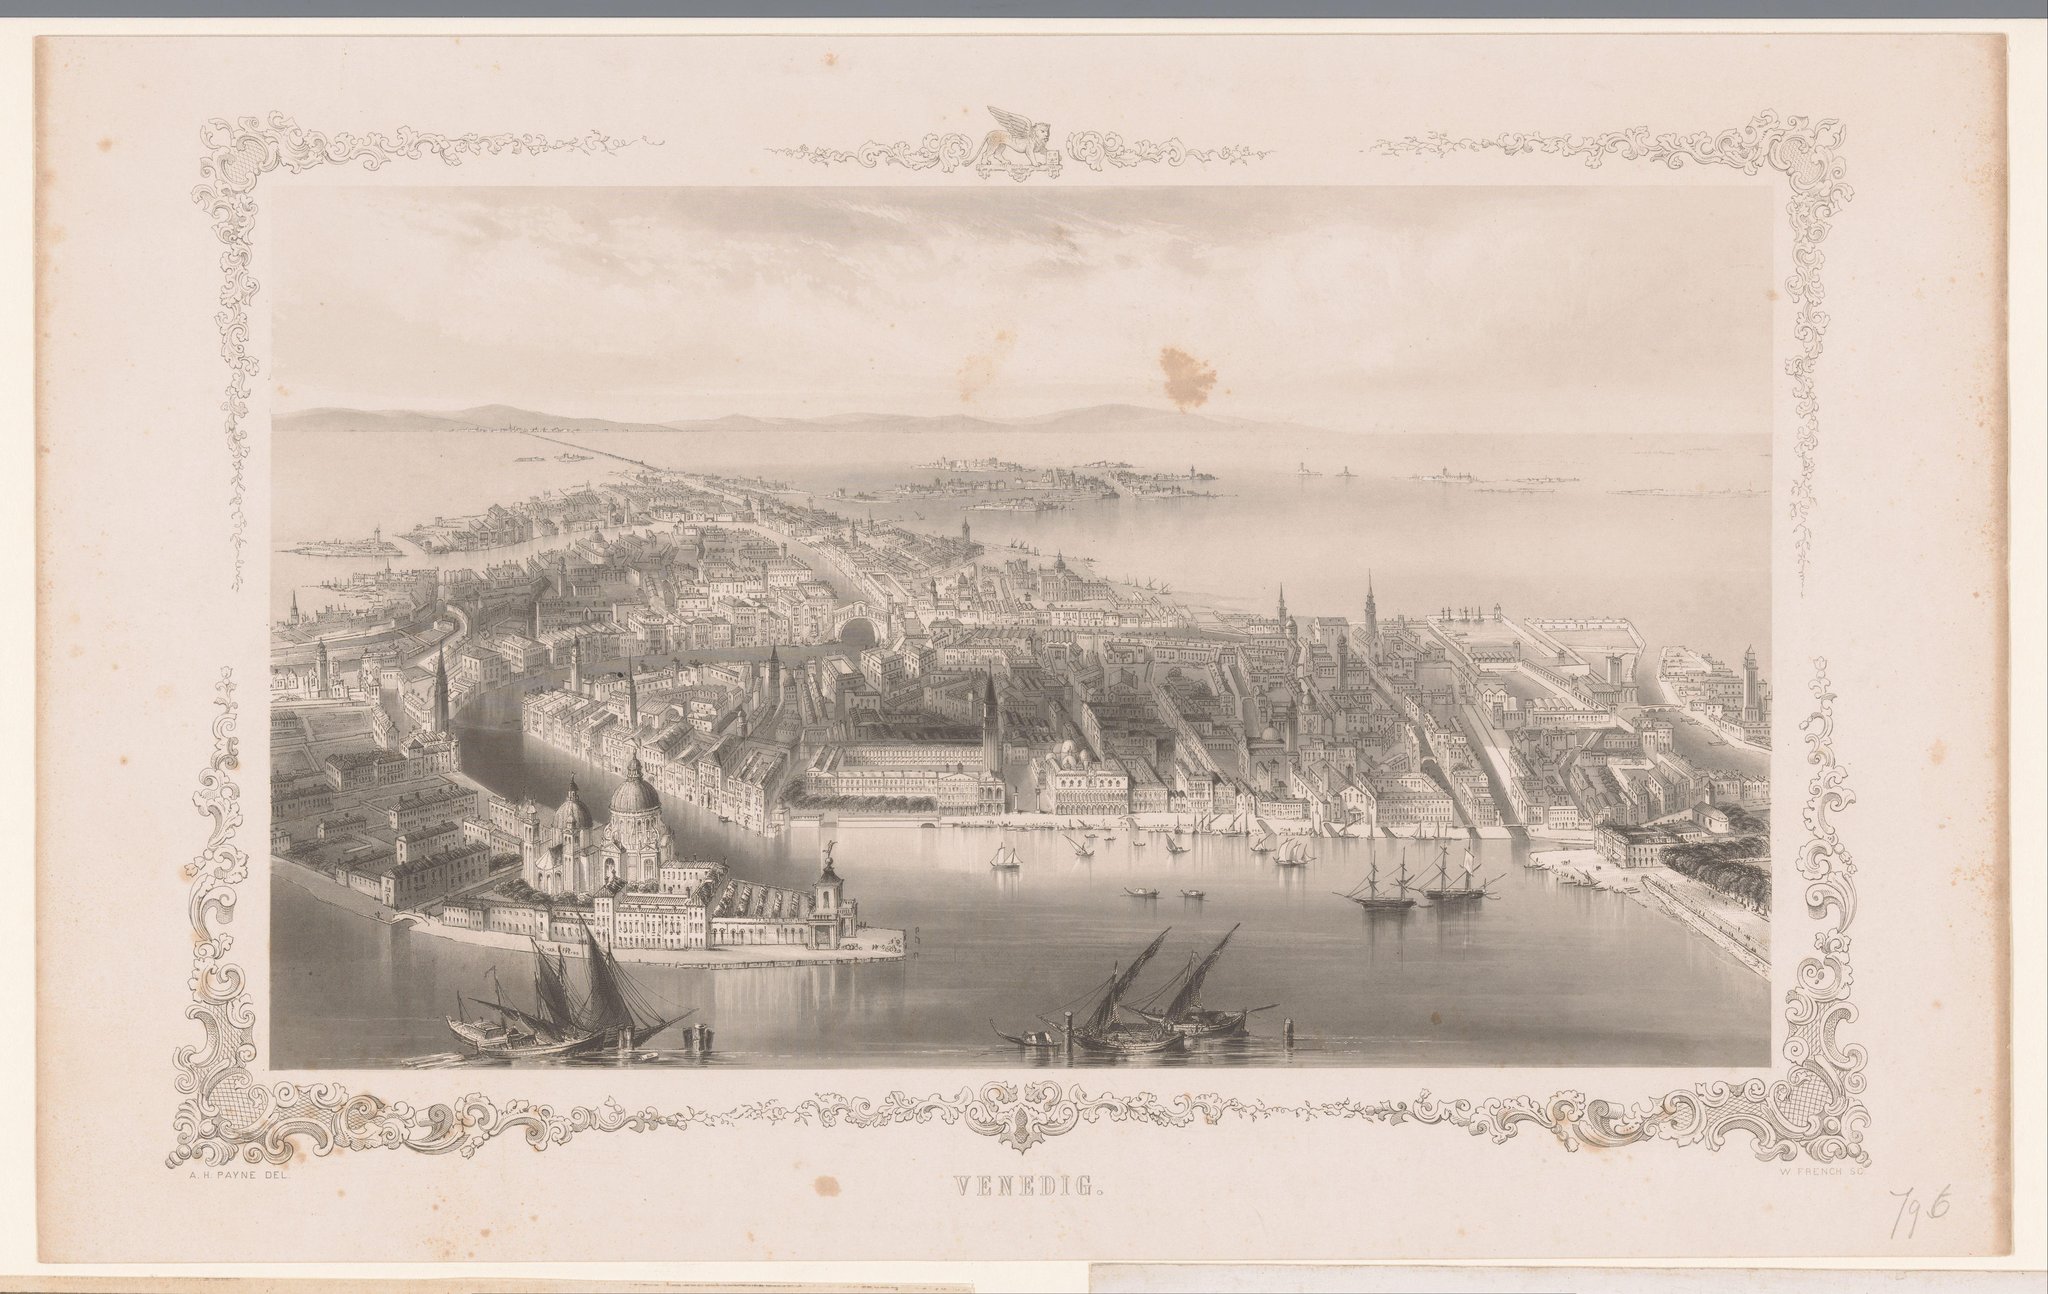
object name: print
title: Gezicht op Venetië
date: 1852-1854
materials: paper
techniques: engraving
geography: leipzig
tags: harbour, city-view, and landscape with man-made constructions, venice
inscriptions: collector's mark: Lugt 2228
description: Prent uit: Central-Europa. Panoramische Ansichten der vorzüglichsten Haupt- und Residenzstädte, der wichtigsten See- und Handelsplätze, so wie der merkwürdigsten und interessantesten Gegenden Mittel-Europas, namentlich Deutschlands; nebst historisch-geographischen Text. Leipzig en Dresden: Englische Kunst-Anstalt von A.H. Payne, 1652-1654.